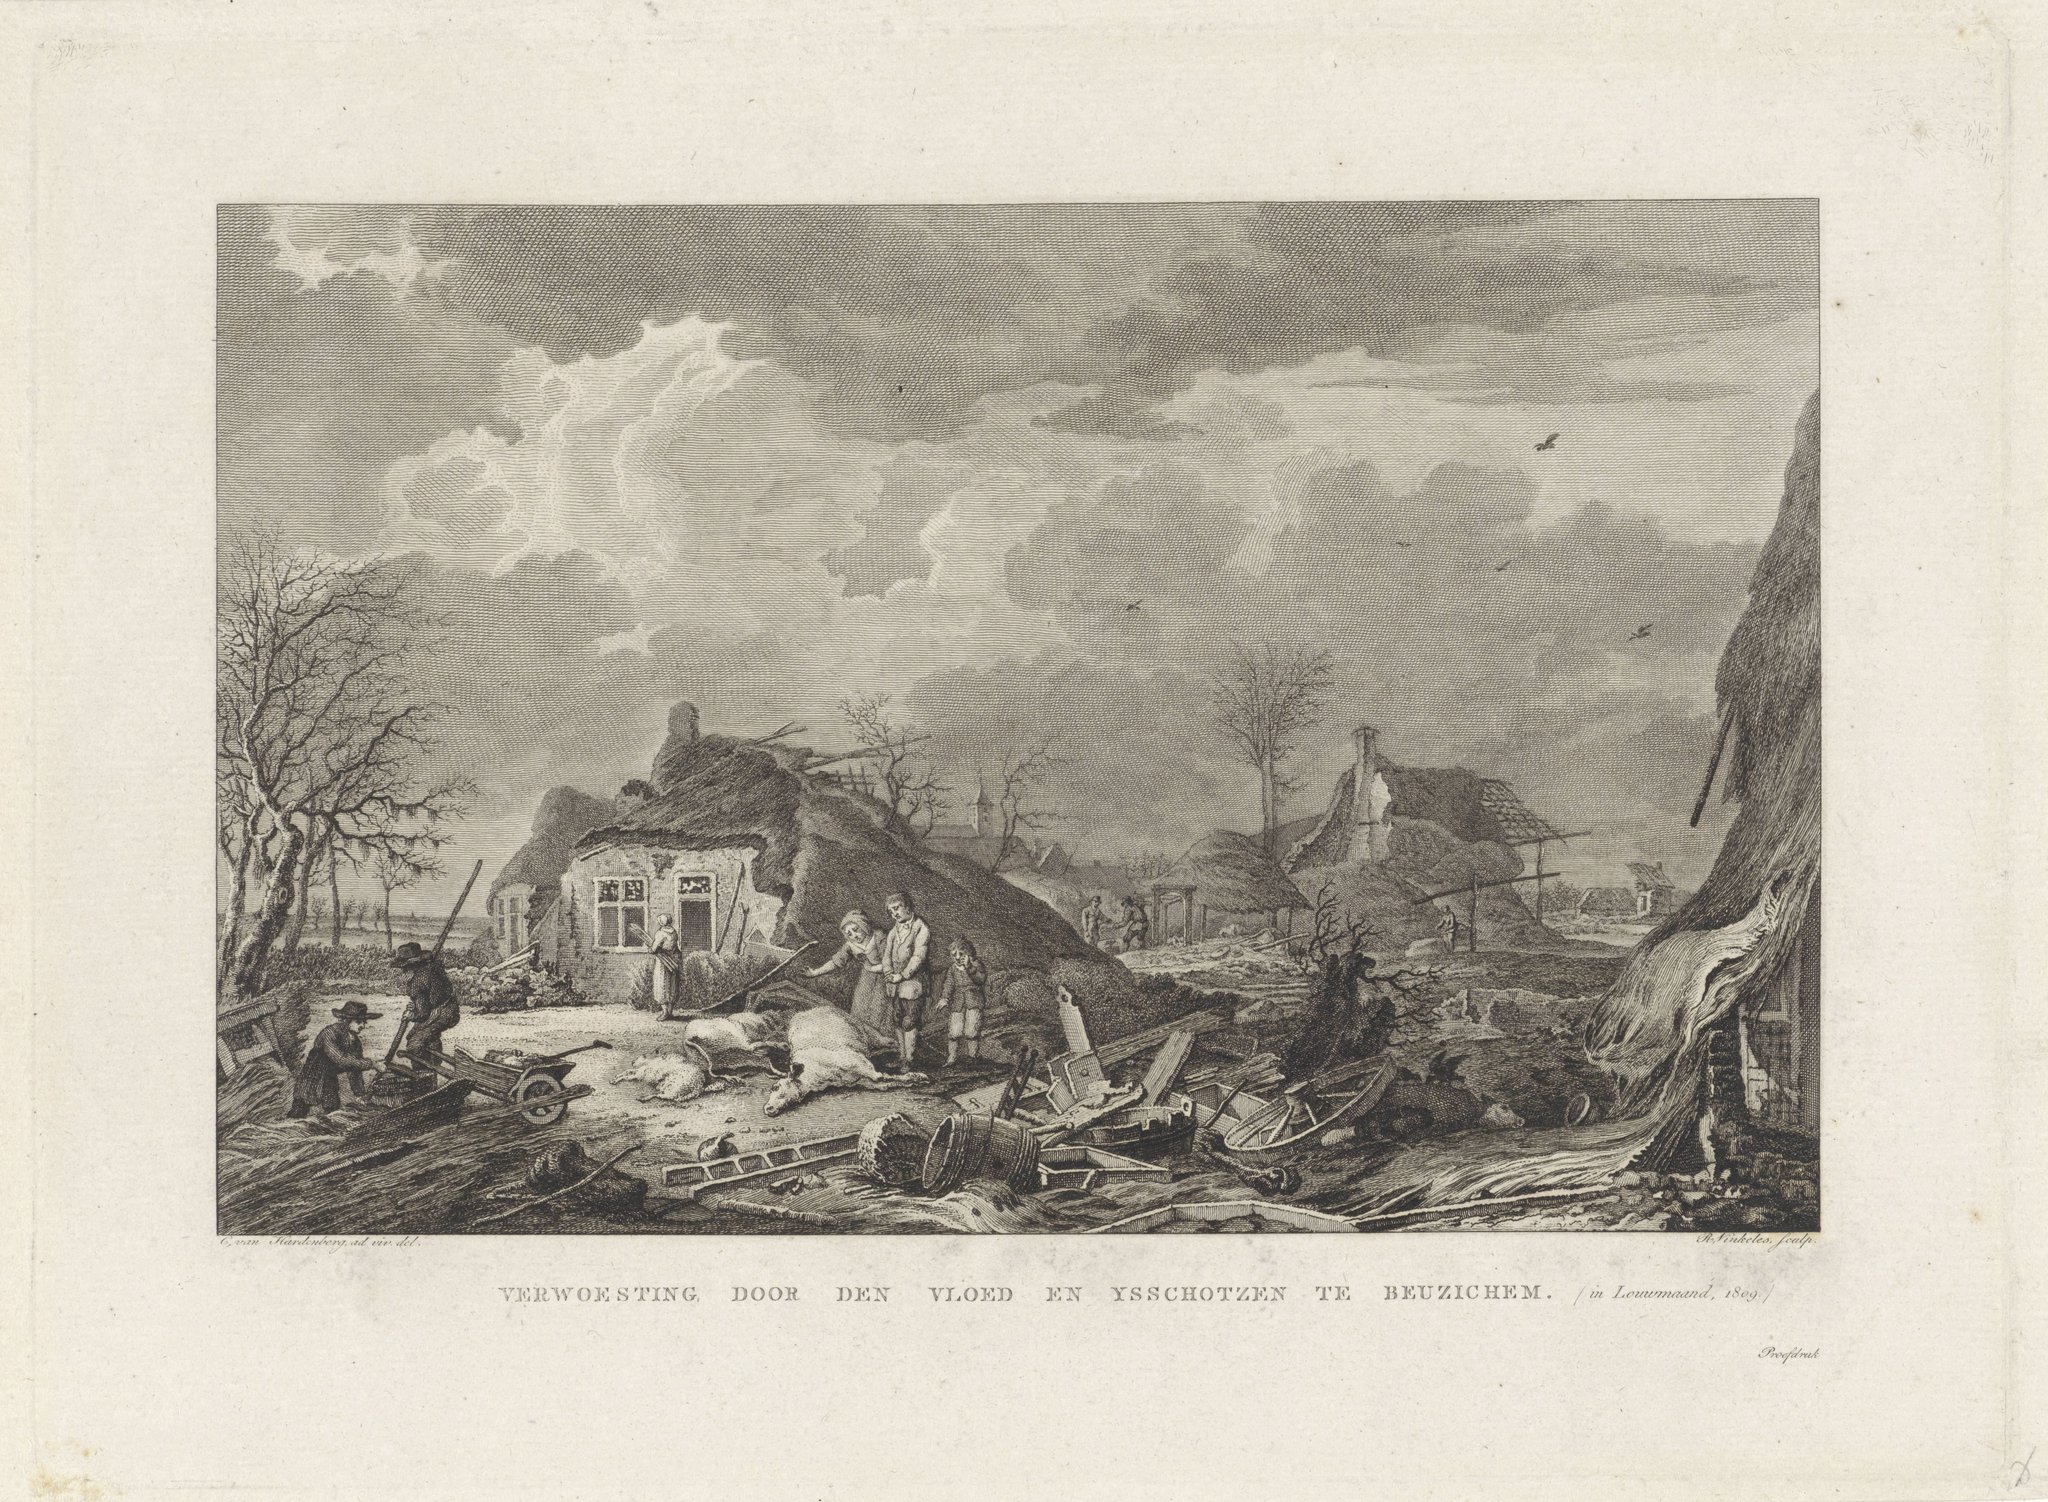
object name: print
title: Verwoesting door de vloed en ijsschotsen te Beusichem, 1809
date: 1809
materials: paper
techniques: engraving, etching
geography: amsterdam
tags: flood (+ landscape with figures, staffage), landscape with ruins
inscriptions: collector's mark: Lugt 2228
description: Illustratie voor: Ewijk, Hendrik. Geschiedkundig verslag der dijkbreuken en overstroomingen in Holland, in 1809. Amsterdam: J. Allart en J. Ruys, 1809.